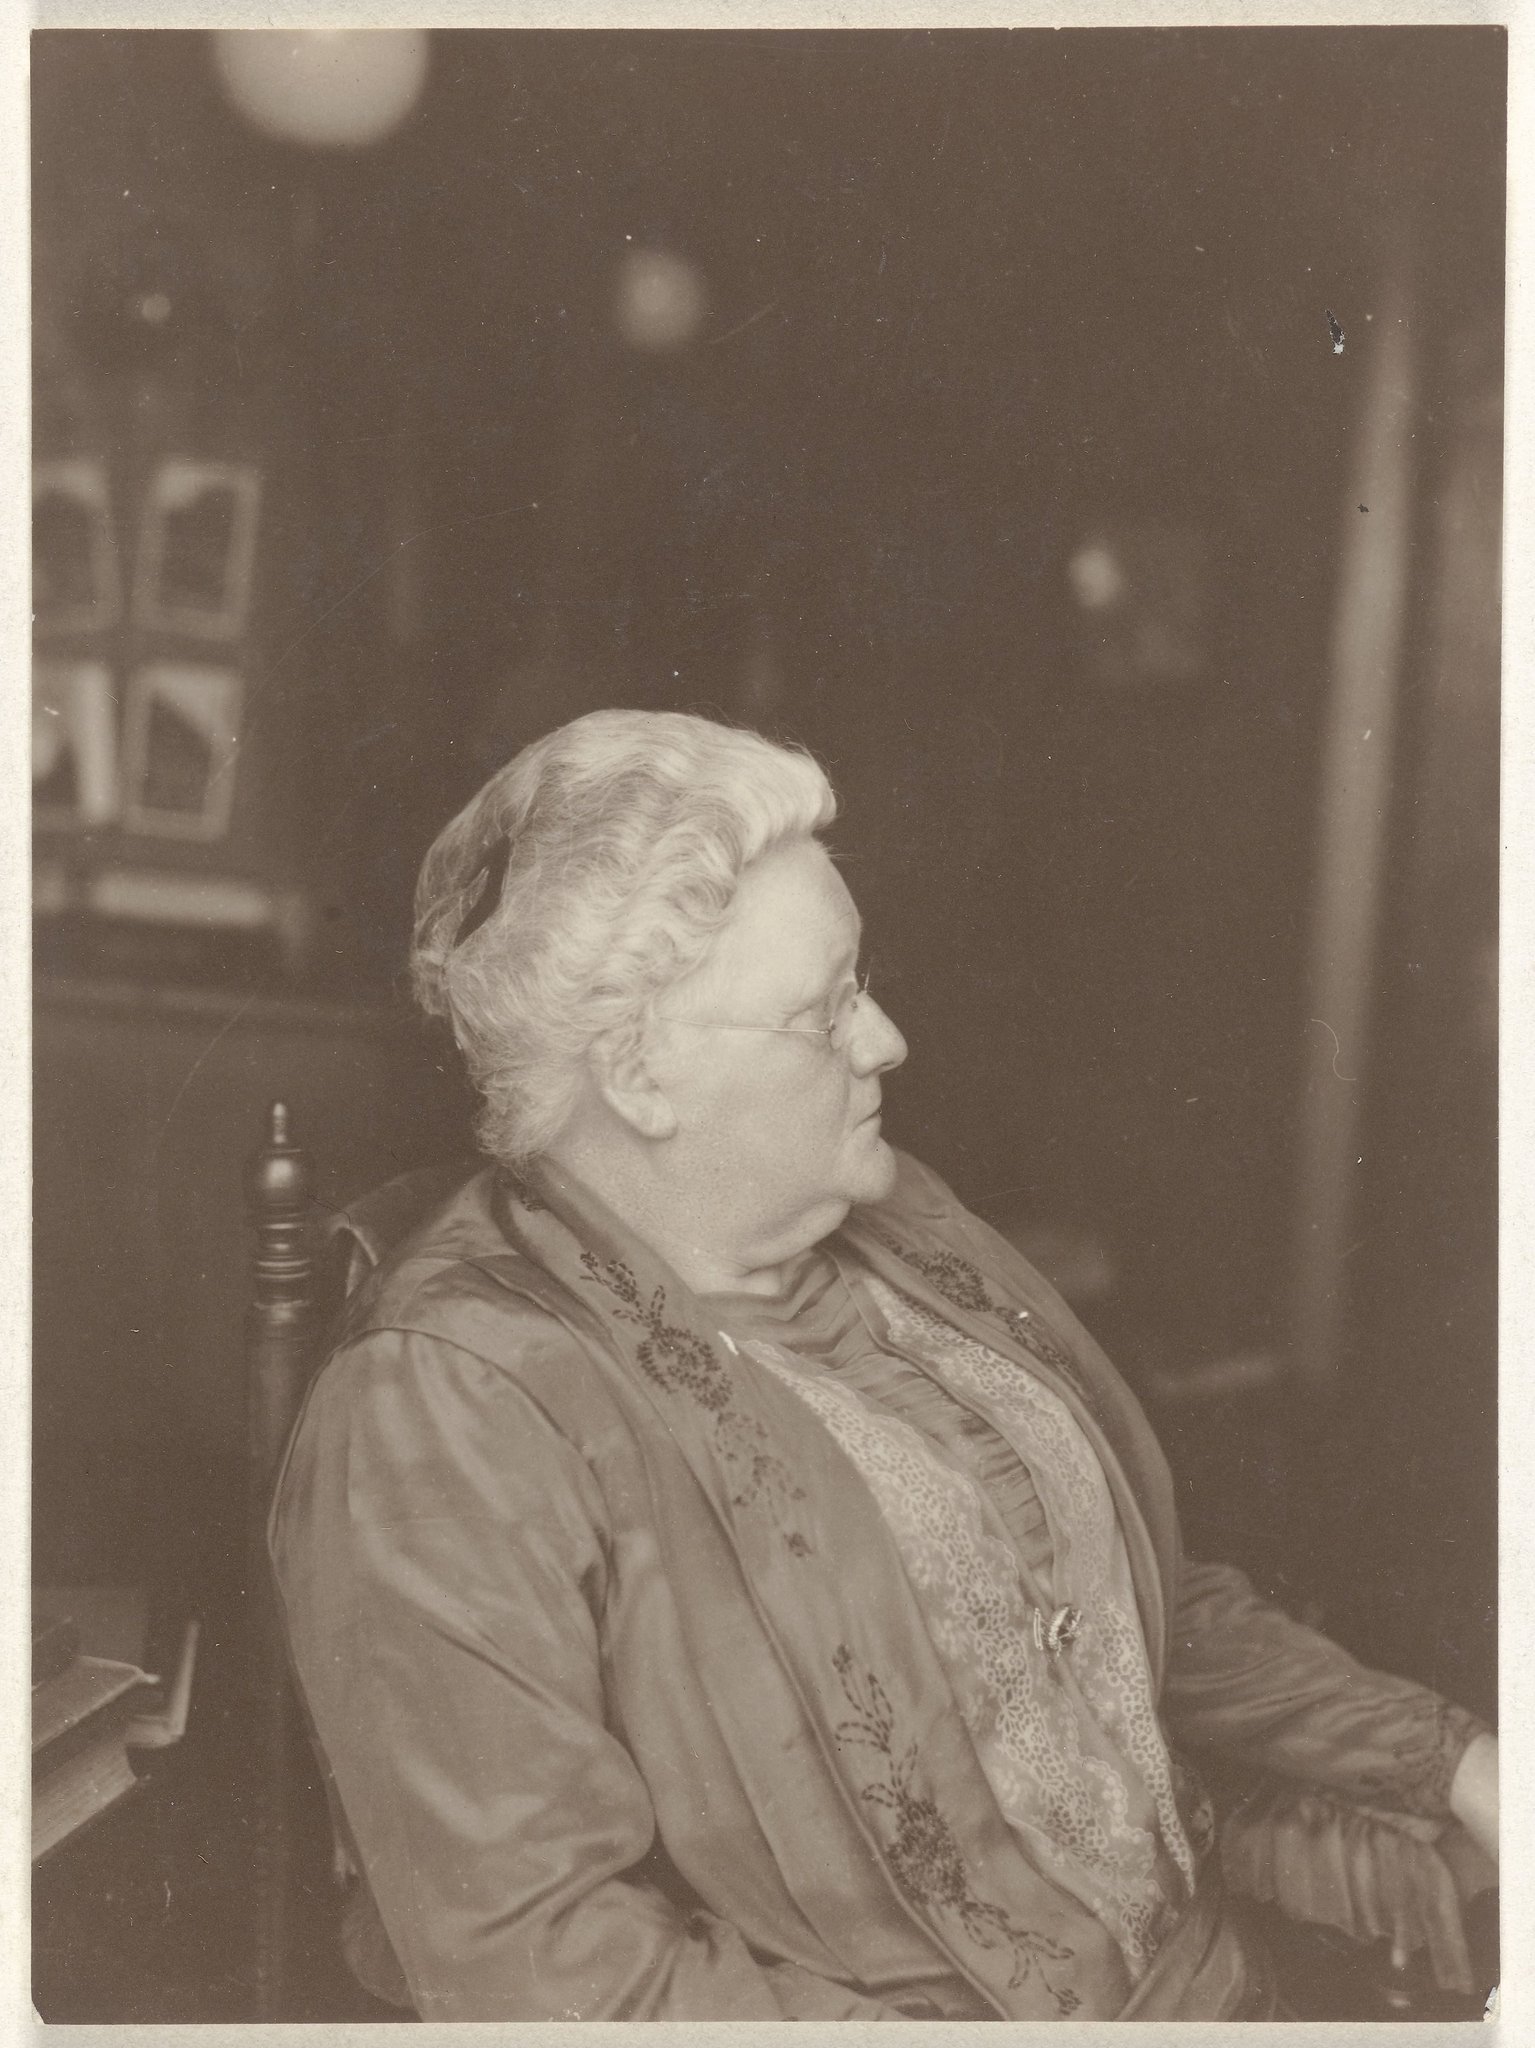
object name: photograph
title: Portret van Grietje Vermeulen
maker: Anonymous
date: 1925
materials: cardboard, photographic support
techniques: matte daylight collodion silver print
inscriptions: annotation: ‘moeder 65 jaar de japon v Flops op de leekamer gemaakt. Wel goed he, voor pa ook’